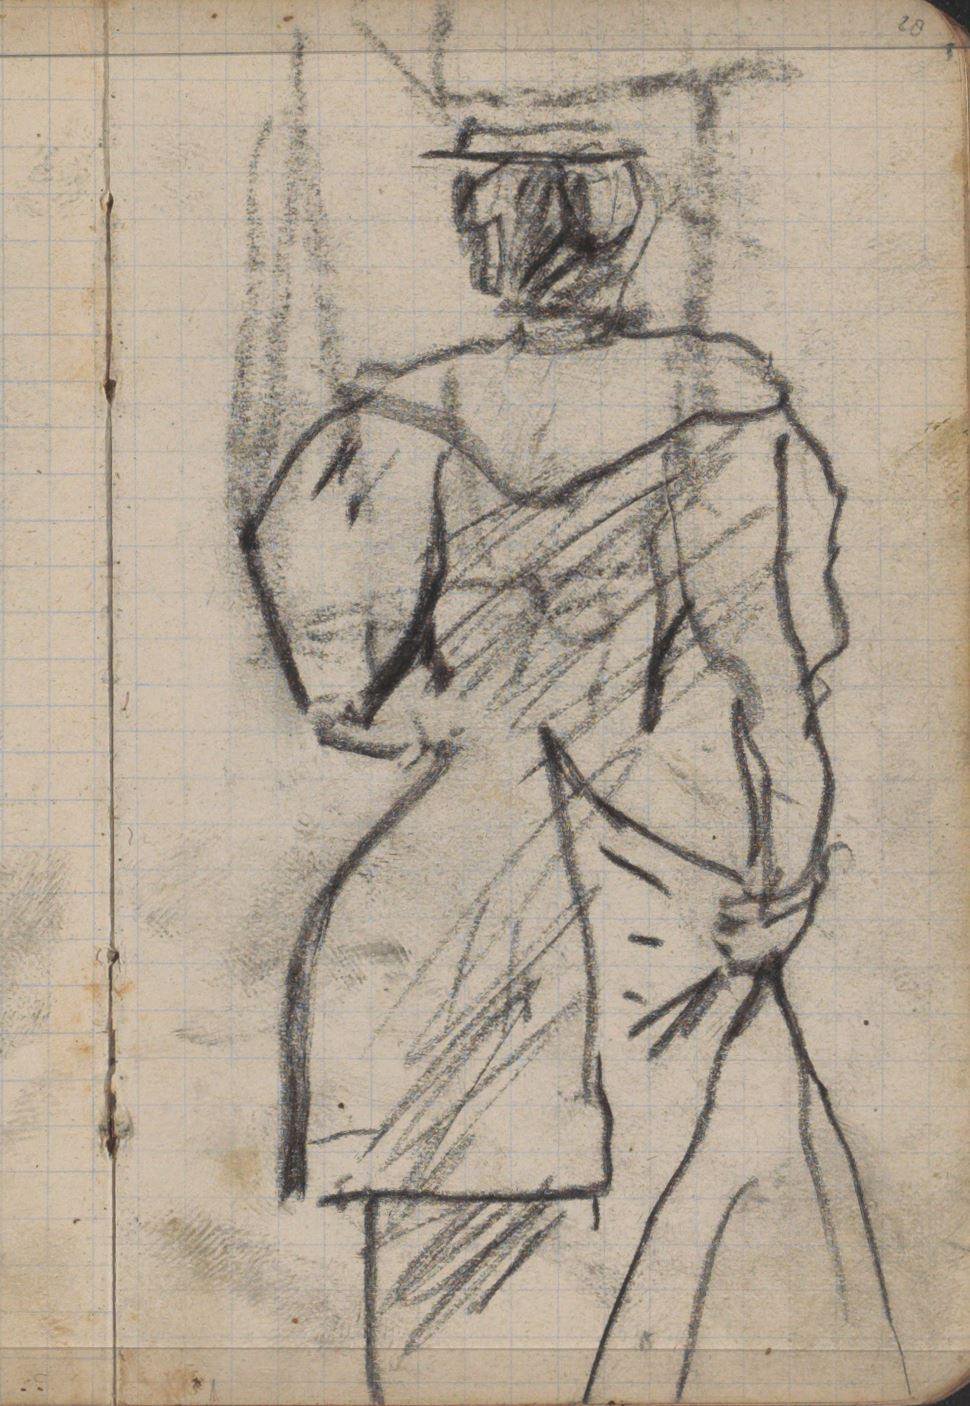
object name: sketchbook leaf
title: Vrouw met hoed, op de rug gezien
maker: george hendrik breitner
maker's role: draughtsman, painter, print maker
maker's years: 1857-1923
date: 1893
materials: chalk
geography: amsterdam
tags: adult woman (+ back view), head-gear: hat (+ women's clothes)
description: Pagina 28 uit een schetsboek met 30 bladen vervaardigd in Amsterdam.